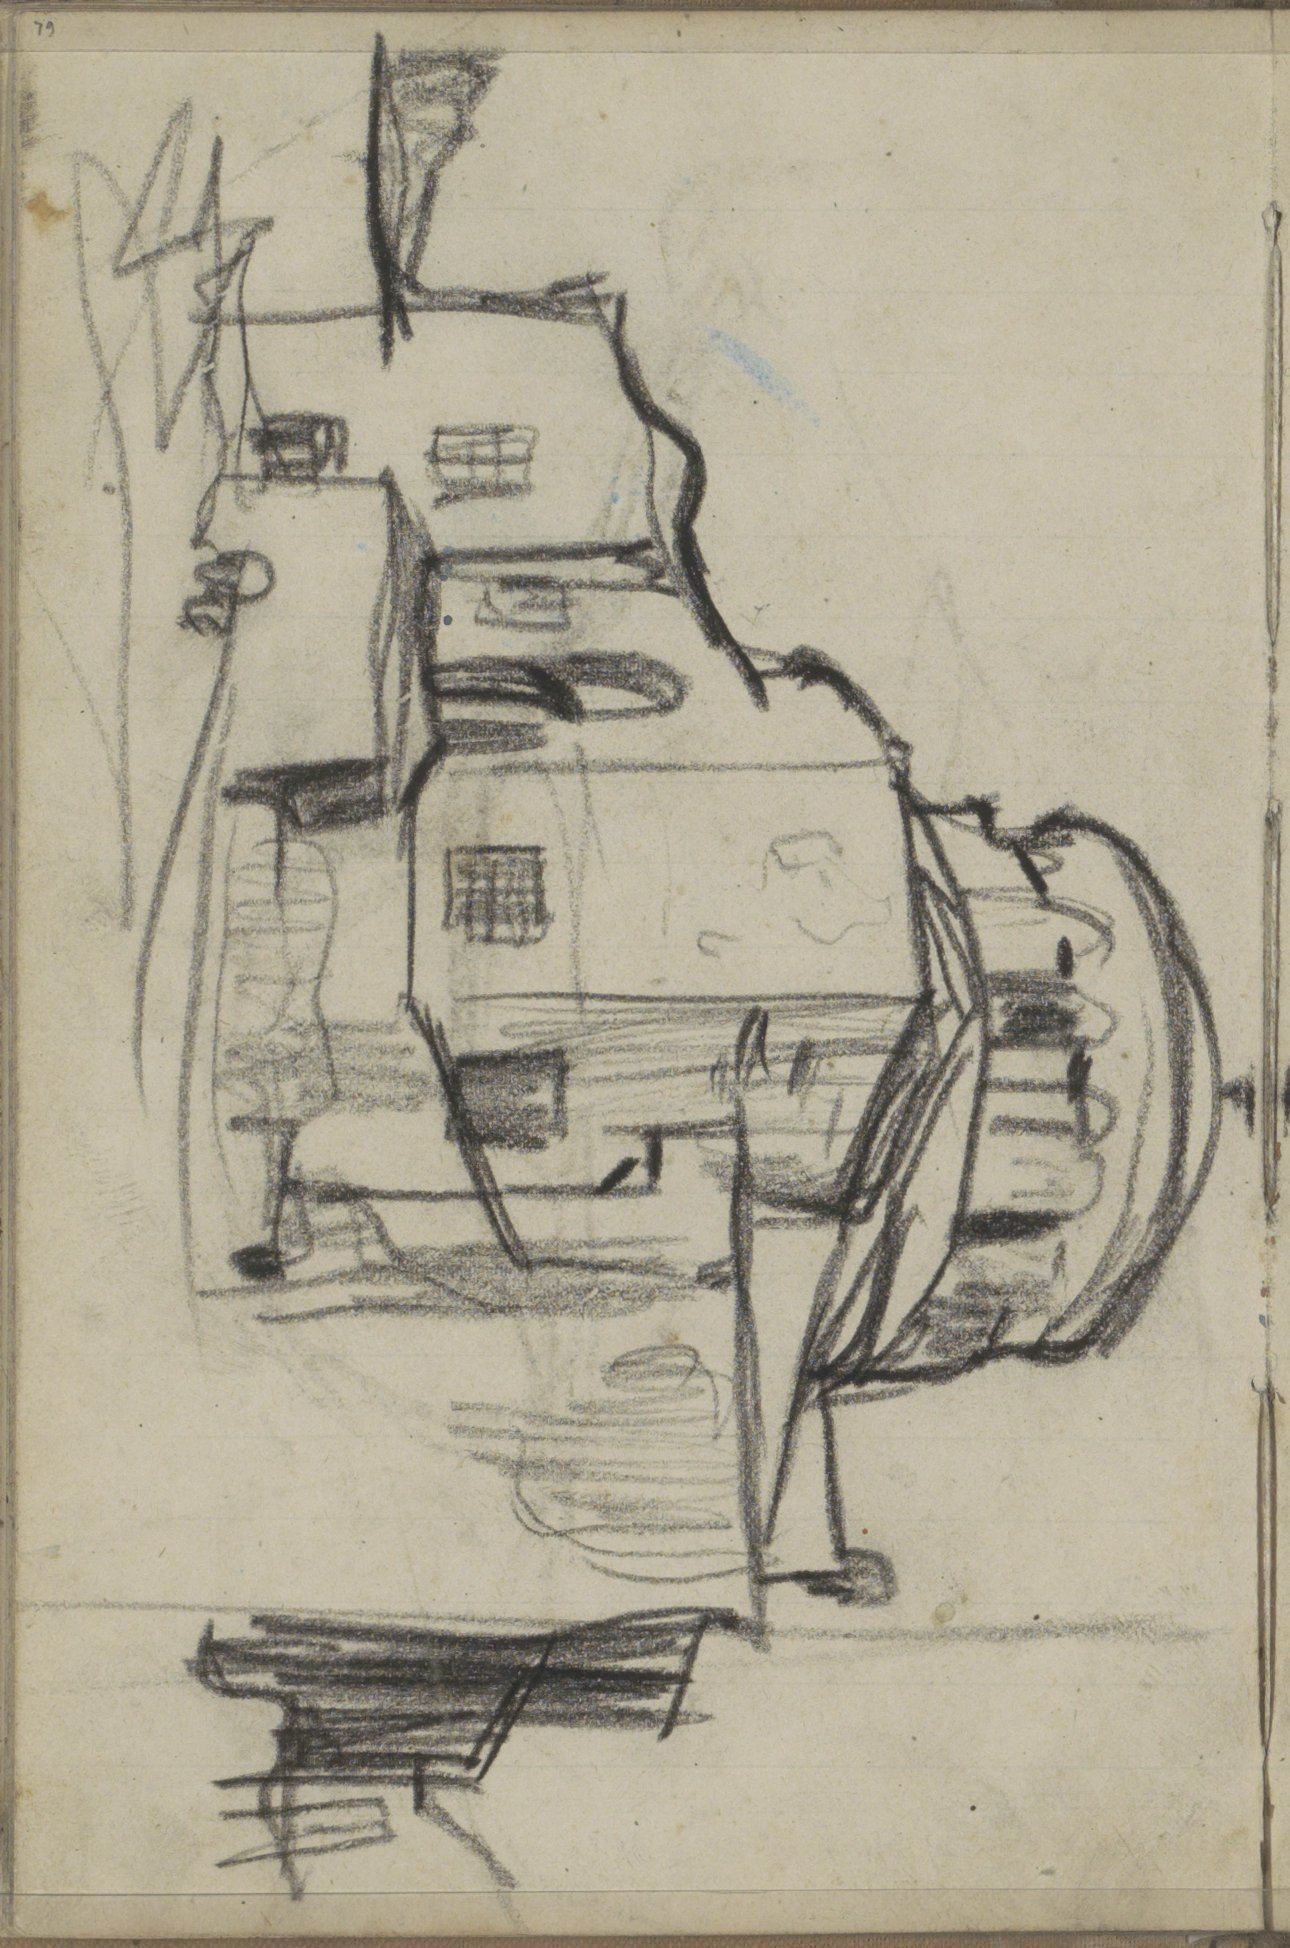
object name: sketchbook leaf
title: Gebouw met een koepeldak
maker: marius bauer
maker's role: draughtsman, print maker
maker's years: 1867-1932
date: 1888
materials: chalk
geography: istanbul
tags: architecture, dome ~ architecture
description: Mogelijk een moskee. Pagina 79 uit een schetsboek met 56 bladen.